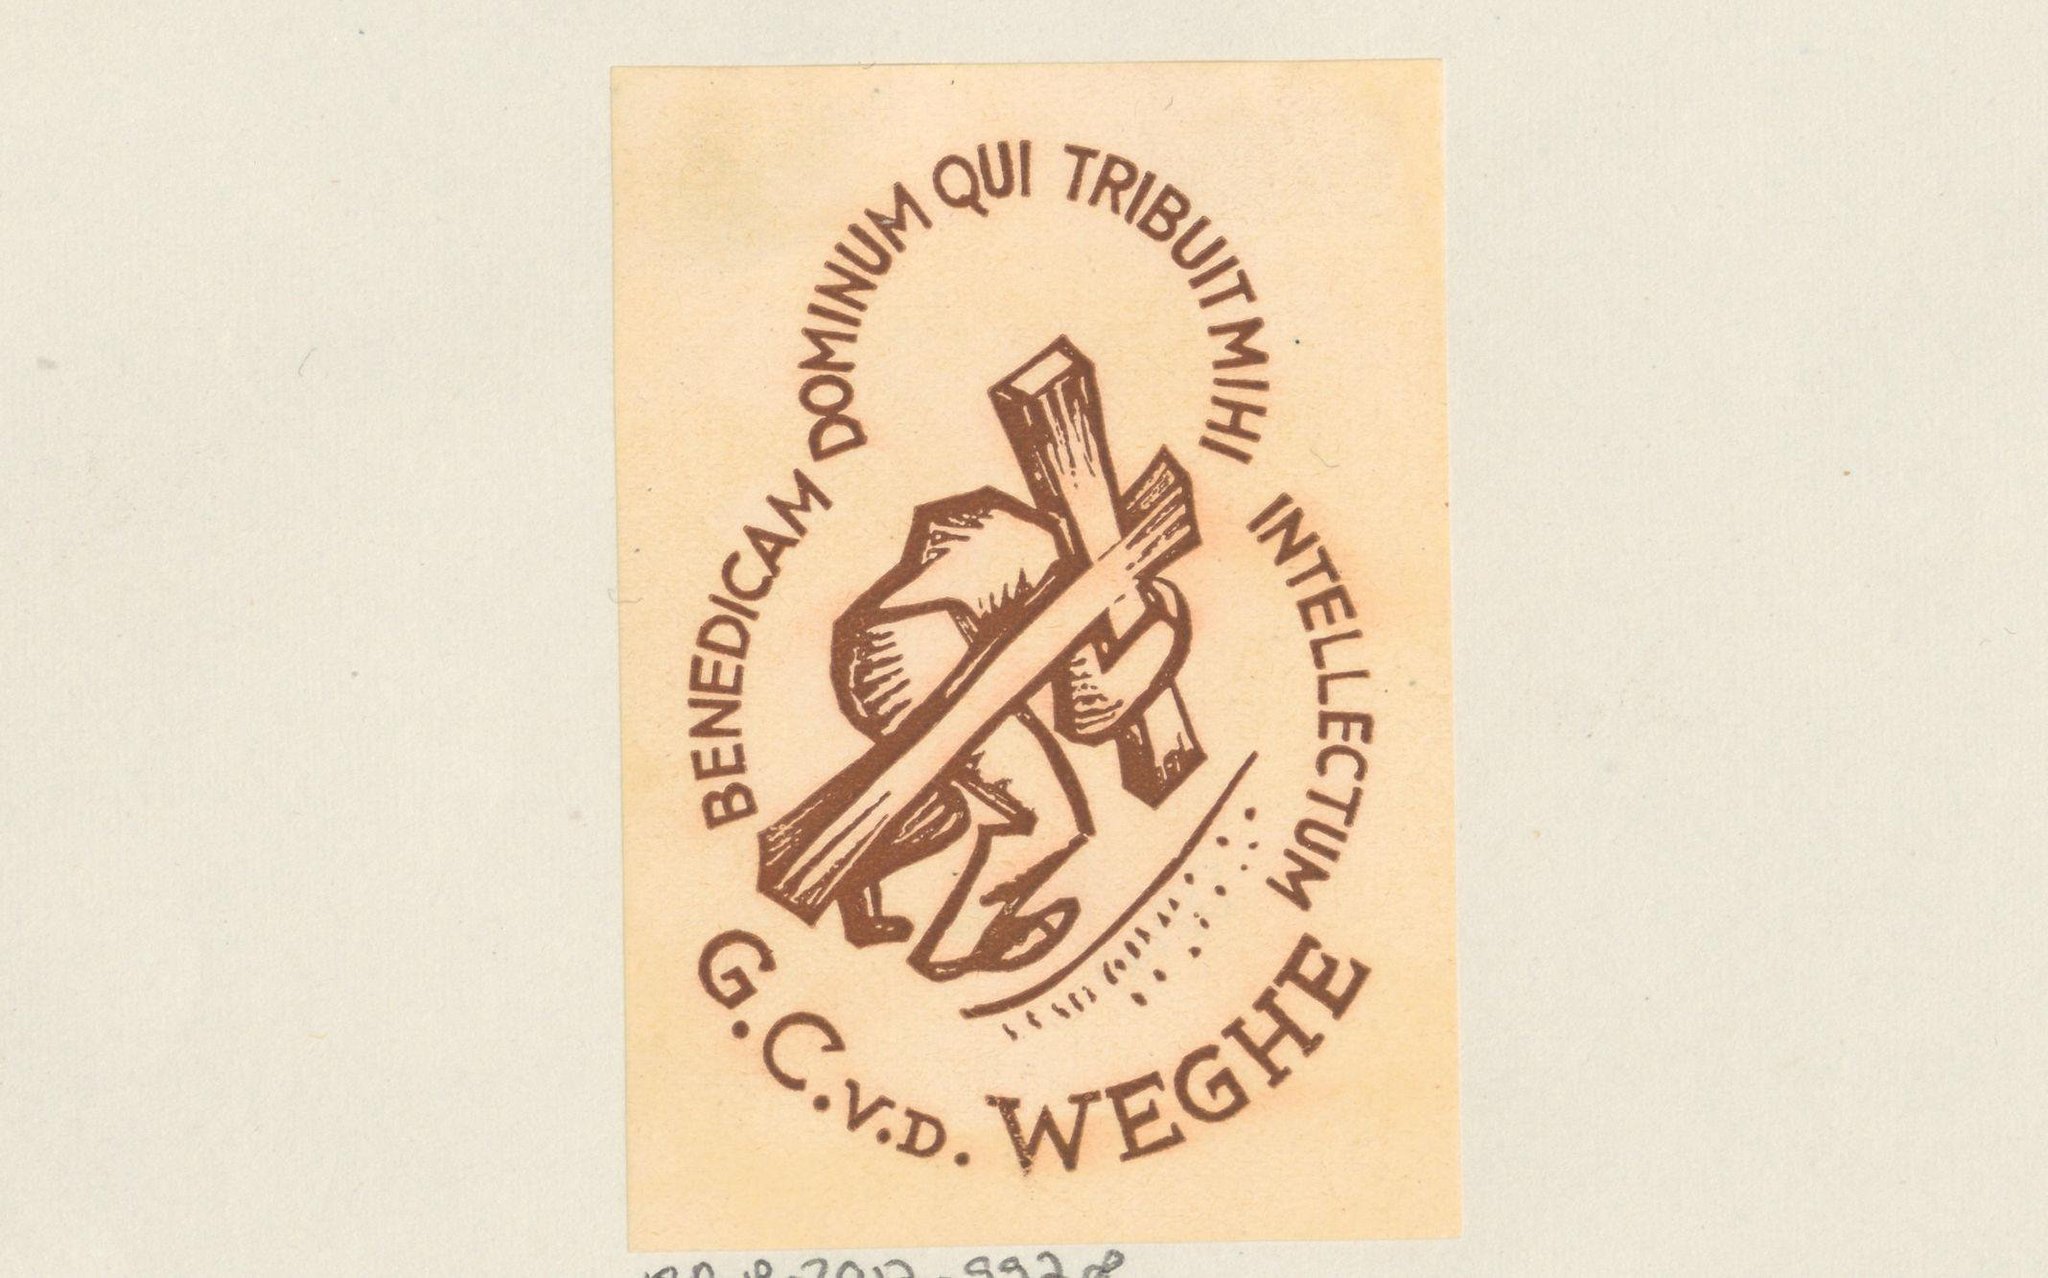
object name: bookplate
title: Benedicam dominum qui tribuit mihi intellectum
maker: Anonymous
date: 1945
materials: paper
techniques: printing block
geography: netherlands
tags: carrying something, the cross ~ symbols of christ